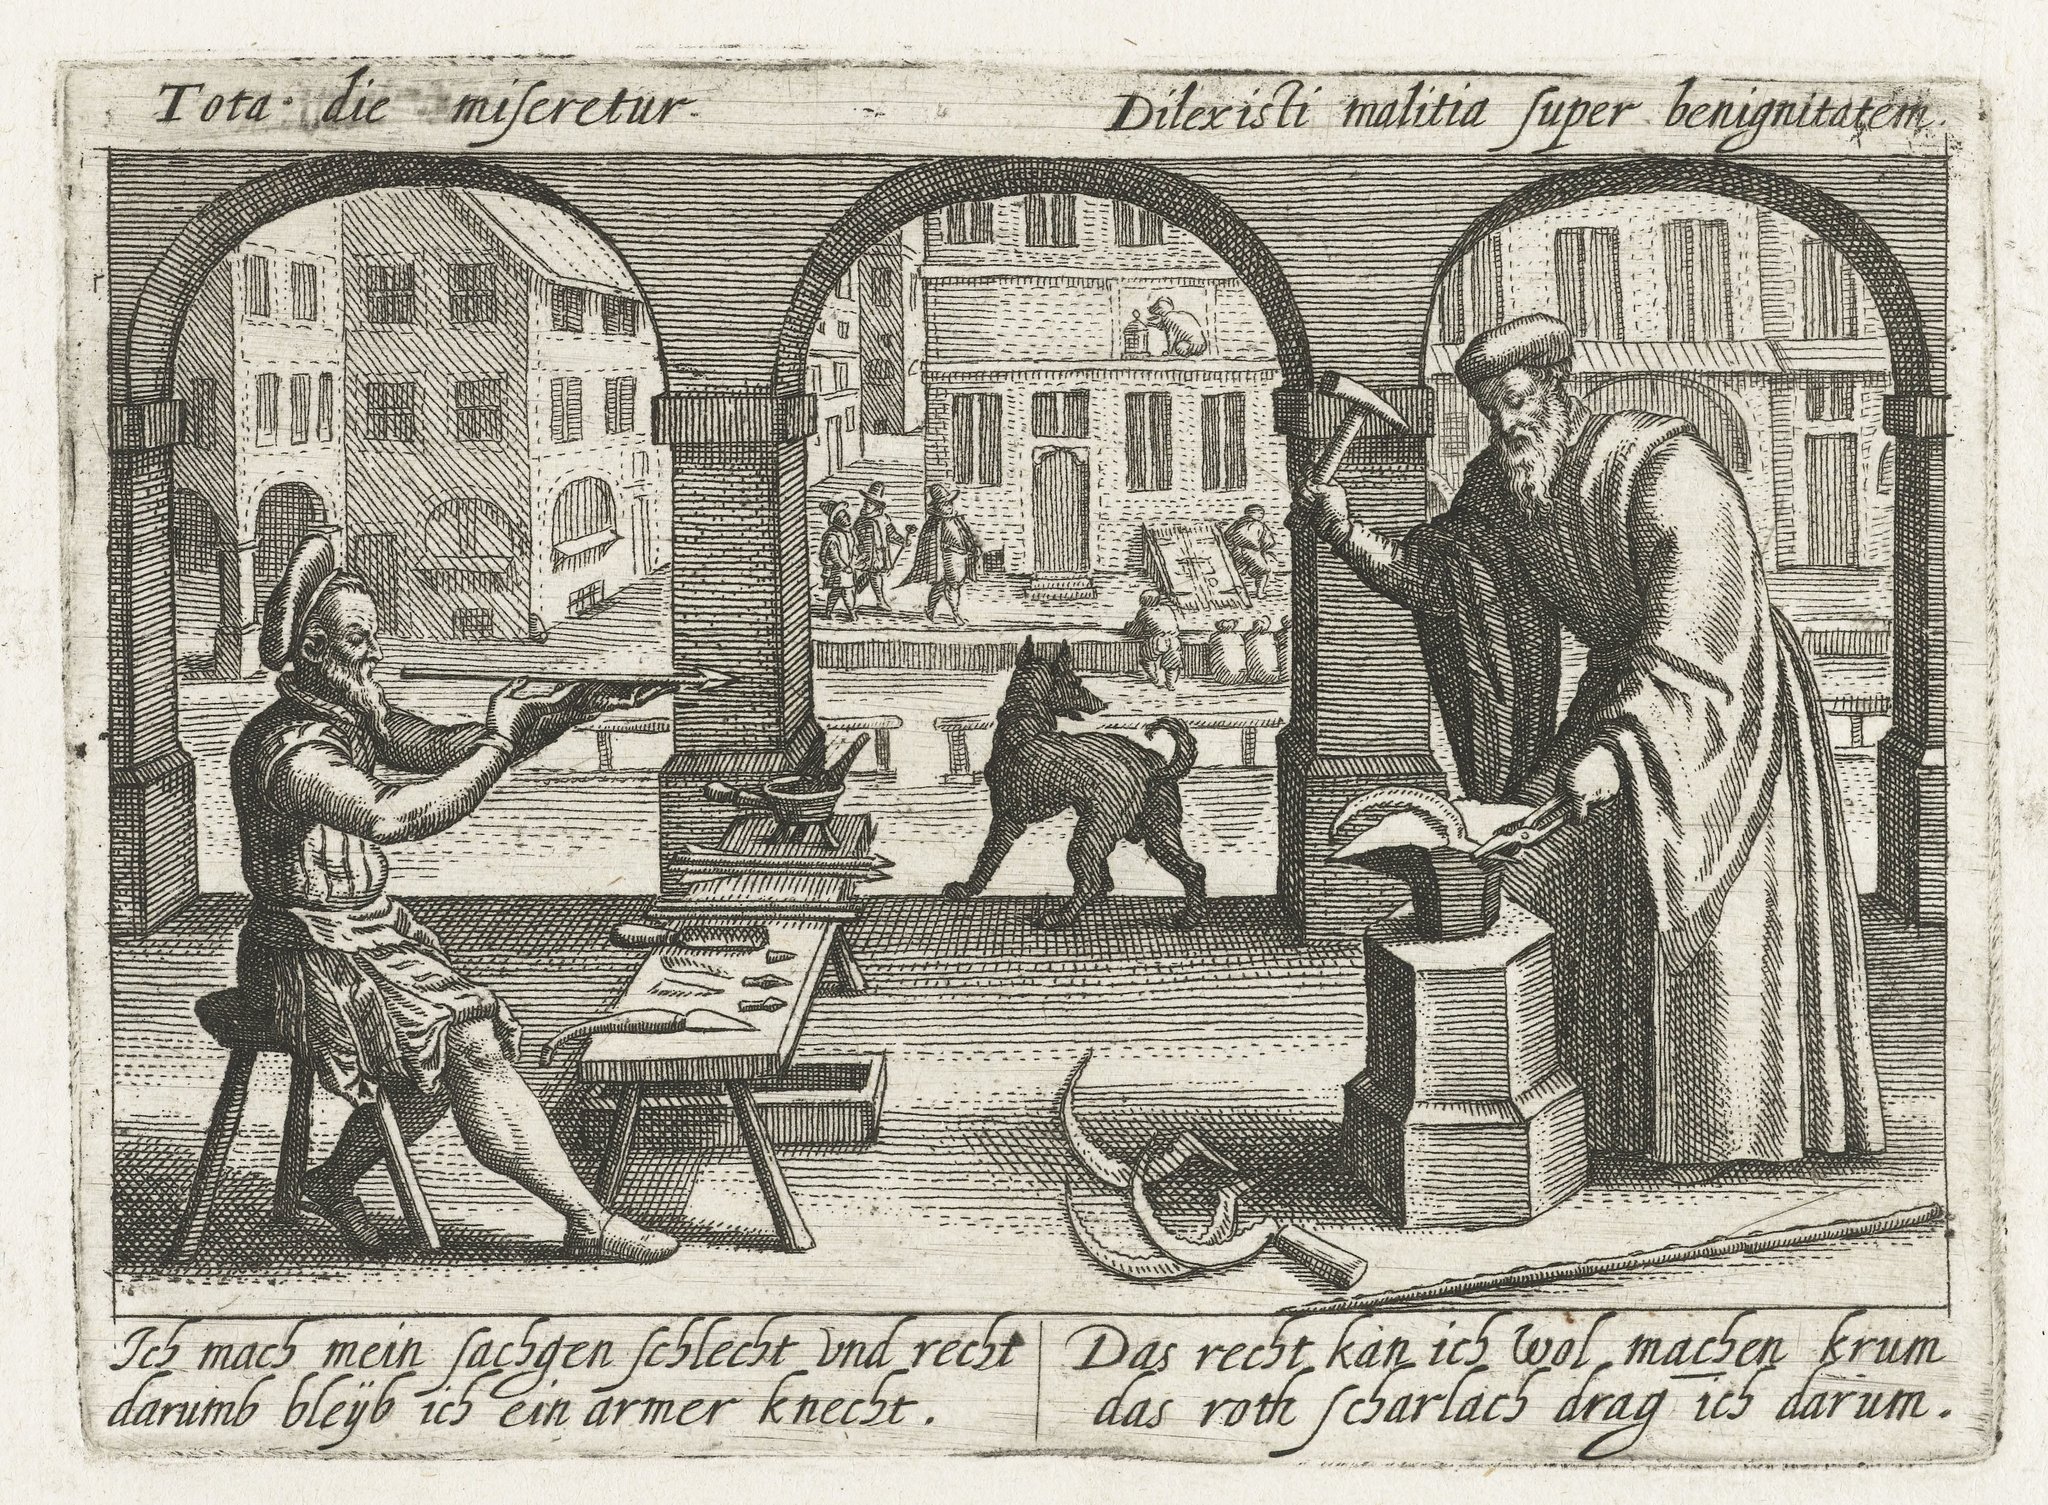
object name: print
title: Pugillus facetiarum iconographicarum in studiosorum (...)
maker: jacob van der heyden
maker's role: draughtsman, print maker, publisher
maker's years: 1573-1645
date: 1608-1618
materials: paper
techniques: engraving, etching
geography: straatsburg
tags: 'album amicorum', 'stammbuch', city-view in general; 'veduta', morality, archer's weapons: arrow, loggia, verandah, porch, agricultural implements: sickle, dog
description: Deze serie, getiteld ‘Pugillus facetiarum iconographicarum in studiosorum (…)’, bestond vermoedelijk uit 36 of meer prenten. Van deze serie zijn in ieder geval twee uitgaven bekend, uit 1608 en 1618. De prenten uit deze serie in de collectie van het Rijksmuseum (RP-P-1996-1 t/m RP-P-1996-36) zijn vermoedelijk afkomstig uit verschillende uitgaven, of uit de tweede uitgave. De inhoud van beide uitgaven verschilt, maar om de precieze inhoud van de verschillende uitgaven vast te stellen is meer onderzoek nodig. Er zijn geen volledige exemplaren van de eerste uitgave bekend. Aan de hand van de analyse van een andere serie, ‘Jeucht spieghel’,* die kopieën van ‘Pugillus’ bevat en is uitgegeven in 1610 én de aanwezige exemplaren van prenten uit ‘Pugillus’ in een inmiddels verloren album amicorum uit 1610,** kan in ieder geval van een aantal prenten gesteld worden dat ze al voorkwamen in de uitgave van 1608. Dit geldt voor RP-P-1996-1 (de titelprent), RP-P-1996-5, RP-P-1996-6, RP-P-1996-7, RP-P-1996-8, RP-P-1996-9, RP-P-1996-10, RP-P-1996-11, RP-P-1996-12, RP-P-1996-13, RP-P-1996-14, RP-P-1996-15, RP-P-1996-16, RP-P-1996-17, RP-P-1996-18, RP-P-1996-19, RP-P-1996-24, RP-P-1996-28, RP-P-1996-29, RP-P-1996-33 en RP-P-1996-35. Van één prent (RP-P-1996-31) kan vastgesteld worden dat die pas in de latere uitgave van 1618 voorkwam, omdat het kopie is van een prent uit weer een andere serie, ‘Academia sive speculum vitae scholasticae (…)’, die werd uitgegeven in 1612.*** Van de huidige prent is onduidelijk of hij al voorkwam in de uitgave van 1608. * Z.G.H.P.H.S [Zacharias Heyns]. Jeucht spieghel. S.l.s.n., 1610. Voor een gedigitaliseerd exemplaar zie: https://archive.org/details/ned-kbn-all-00000628-001/page/n9/mode/2up. ** Zie: Erman, Wilhelm en Ewald Horn. Bibliographie der deutschen Universitäten, systematisch geordnetes Verzeichnis der bis Ende 1899 gedruckten Bücher und Aufsätze über das deutsche Universitätswesen. Leipzig en Berlijn: Verlag von B.G. Teubner, 1904, dl. 1, p. 826-832, no. 17328. https://archive.org/details/bibliographieder01ermauoft/page/826/mode/2up *** Passe, Crispijn van de (I). Academia sive speculum vitae scholasticae (…). Arnhem: Johannes Janssonius [Jan Jansz.], 1612. Voor een gedigitaliseerd exemplaar zie: http://gallica.bnf.fr/ark:/12148/btv1b55005974h.